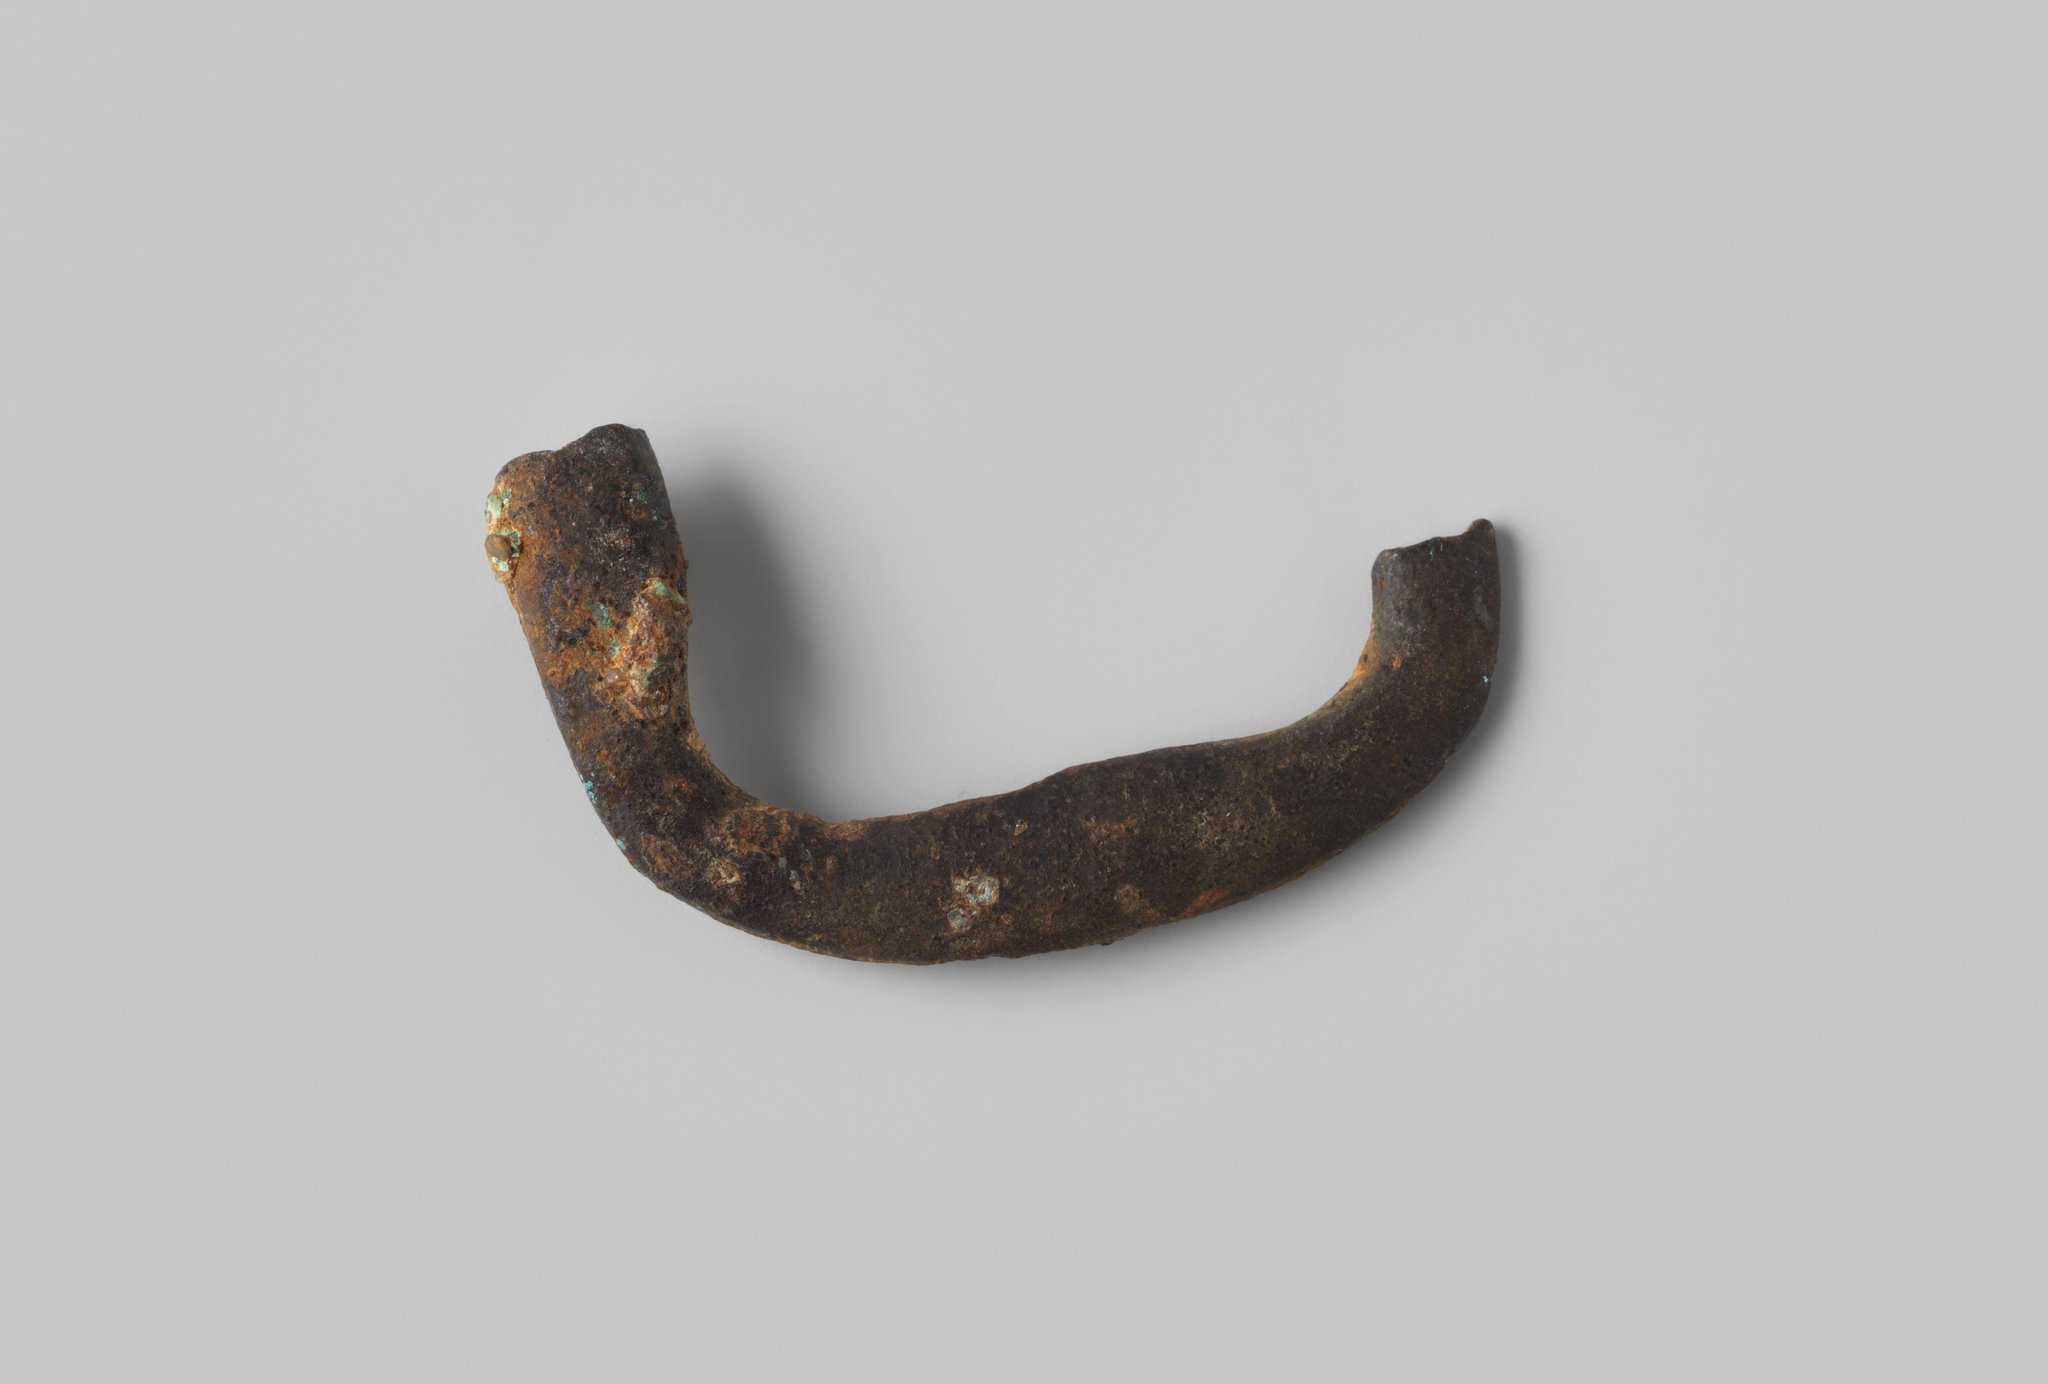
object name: shoe buckle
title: Fragment schoengesp uit het wrak van de Oost-Indiëvaarder Hollandia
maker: Anonymous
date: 1700-1743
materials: copper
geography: netherlands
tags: verenigde oostindische compagnie, hollandia (schip), annet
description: Buckle, chape buckle, shoe buckle; fragment of ring, id. NG 1980-27H1340.